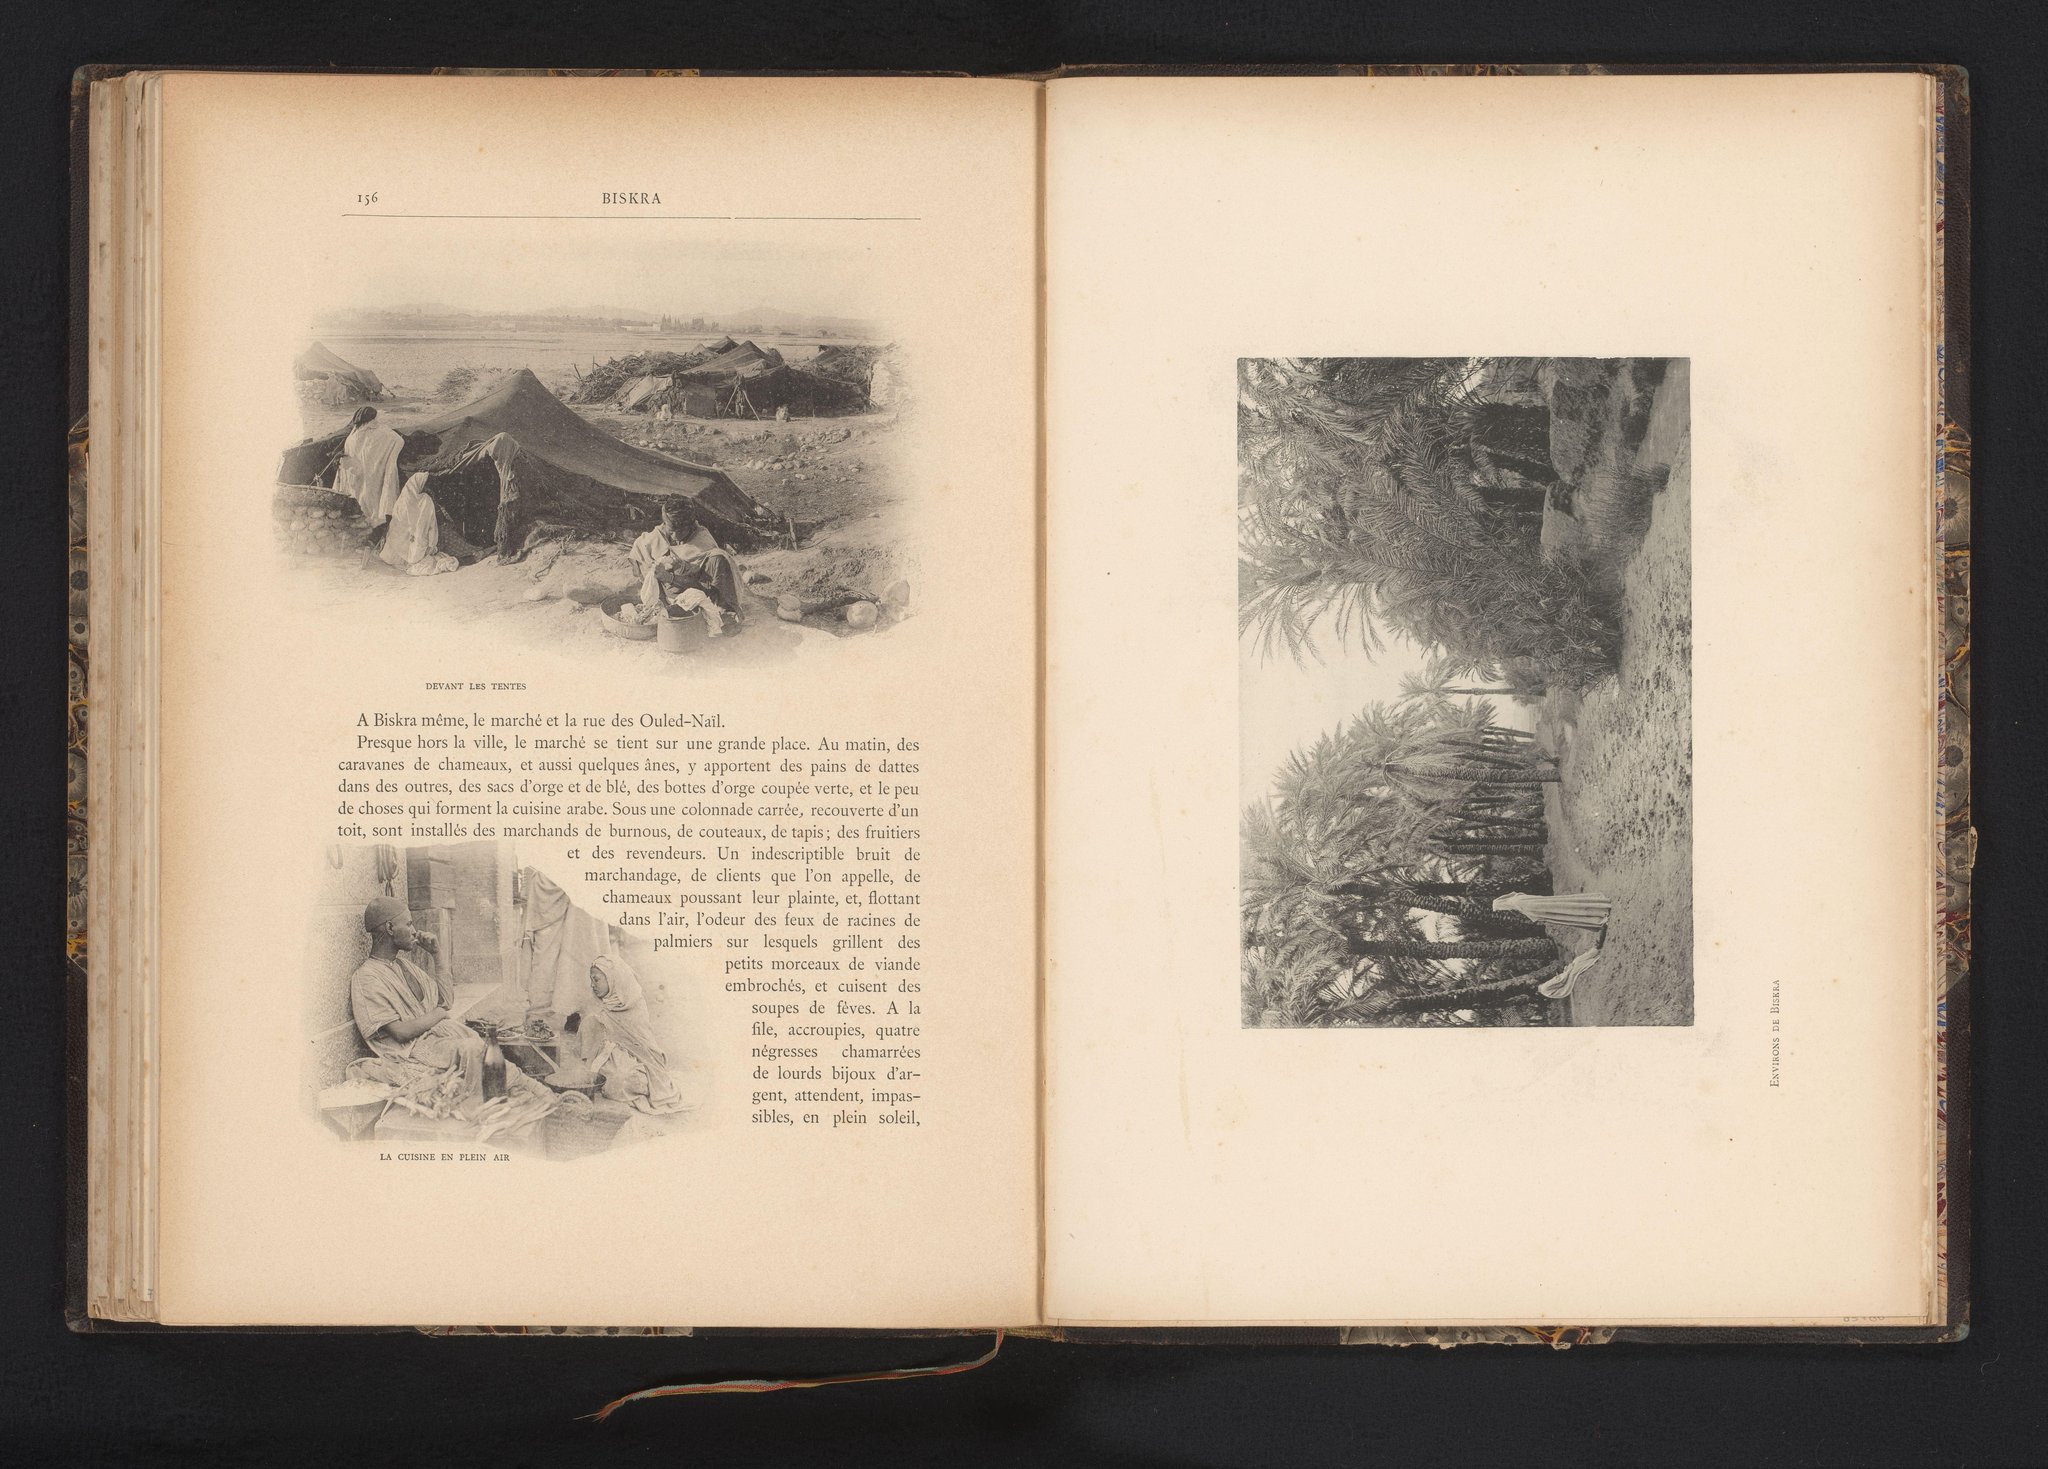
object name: photomechanical print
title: La Cuisine en Plein Air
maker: jules gervais-courtellemont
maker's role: fotograaf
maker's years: 1863-1931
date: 1888-1893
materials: paper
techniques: photograph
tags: adult woman, adult man, cooking food - cc - in the open air